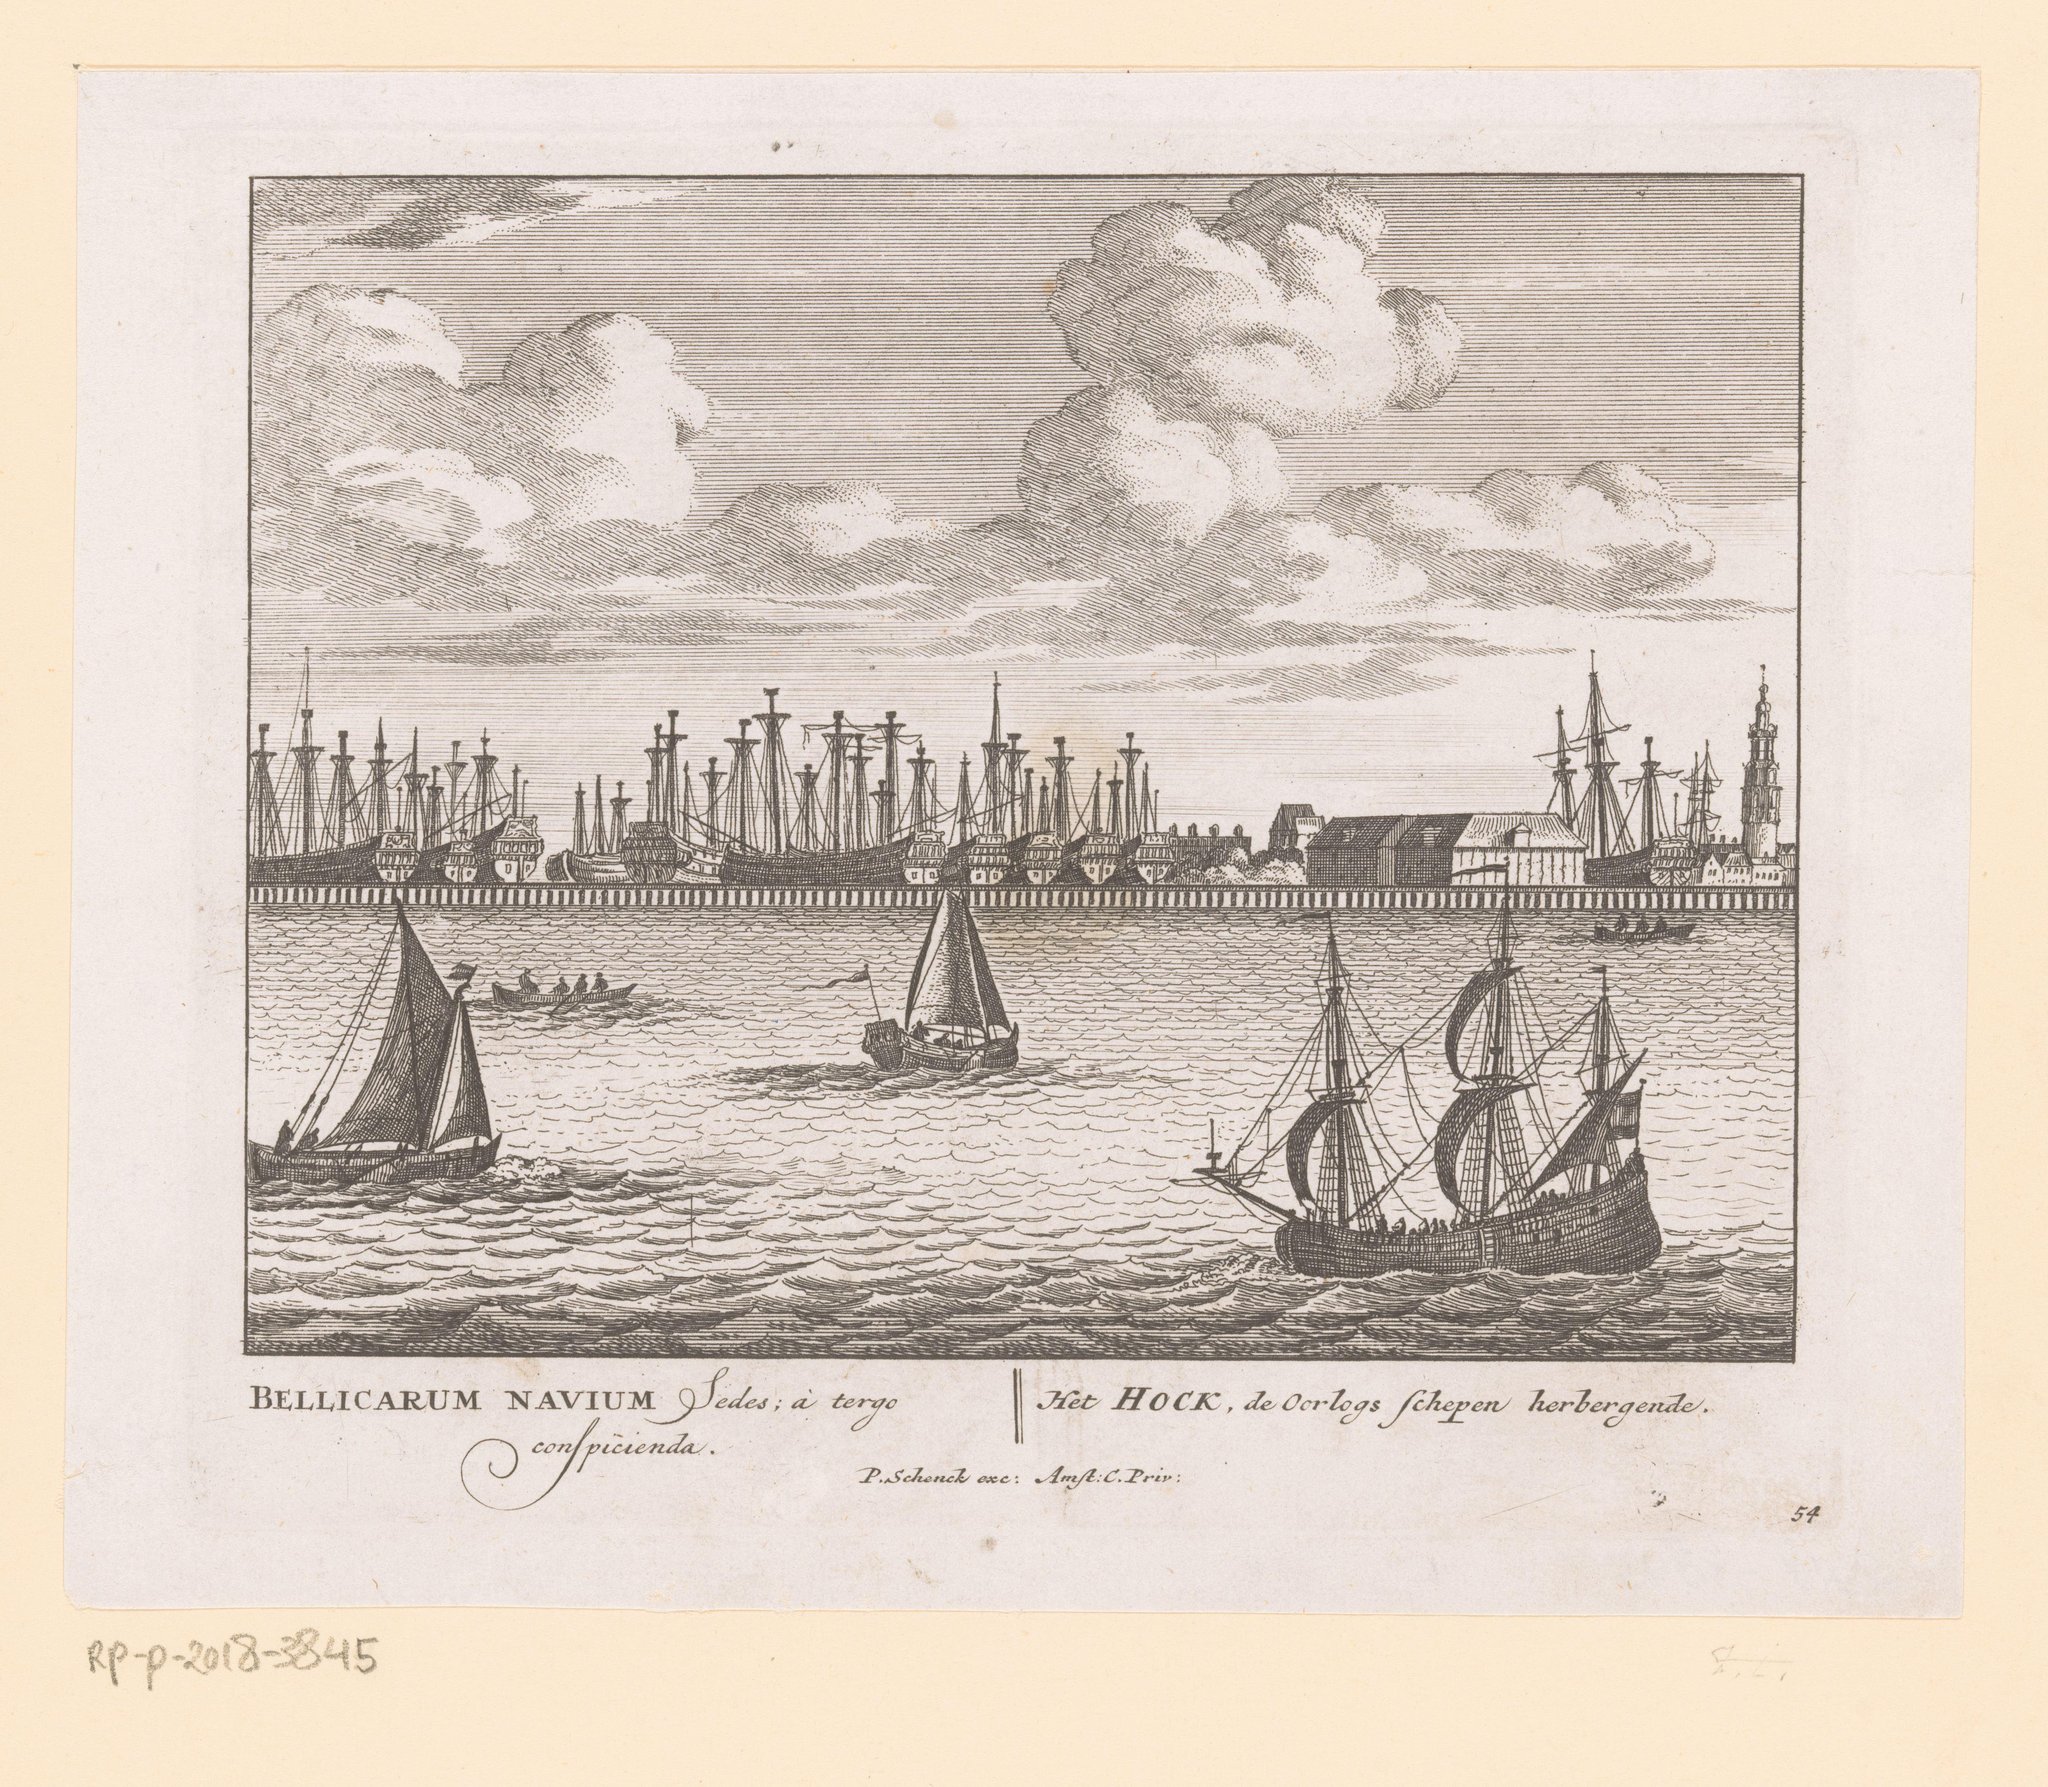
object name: print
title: Bellicarum navium sedes; a tergo conspicienda / Het hock, de Oorlogs Schepen herbergende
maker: Anonymous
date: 1710-1711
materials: paper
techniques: etching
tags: canals, waters (in city), ships (in general) - cc - more than one ship, shipyard, shipdock - cc - more than one ship, amsterdam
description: Huidige staat van prent ook gebruikt in: 100 Afbeeldinge der voornaamste gebouwen van Amsterdam. Amsterdam: Pieter Schenk (I), s.a. [1710-1711]. En in: 100 Afbeeldinge der voornaamste gebouwen van Amsterdam. Amsterdam: Barent Greve, s.a. [1757-1766].* *In de tweede uitgave, uitgegeven door Barent Greve, is alleen de titelprent aangepast. De overige prenten zijn onveranderd gebleven.